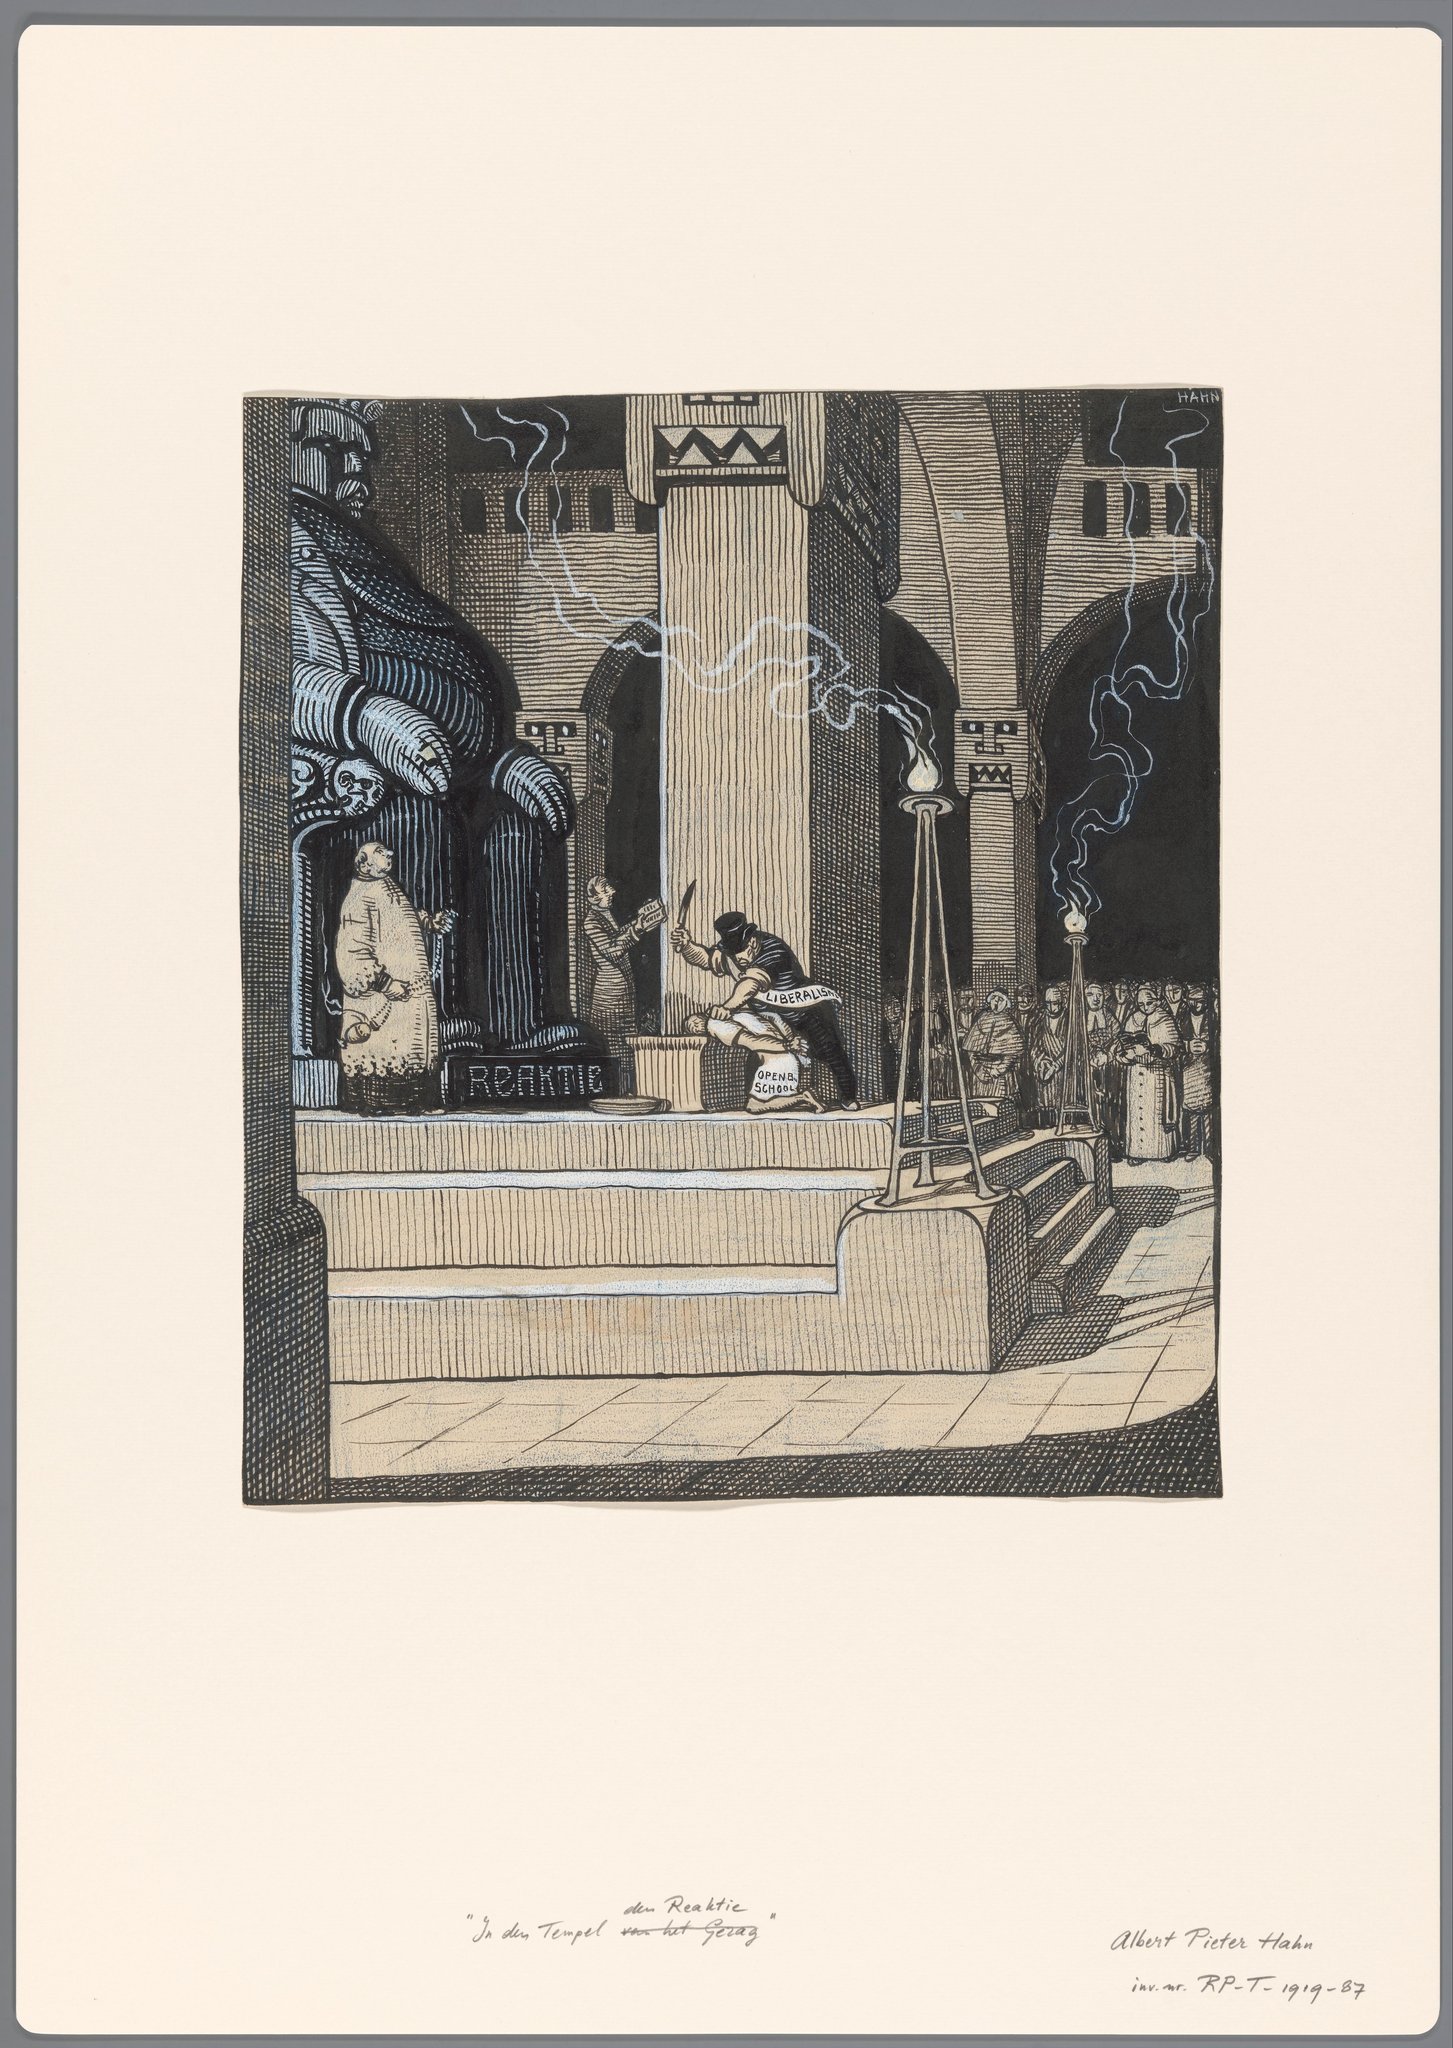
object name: drawing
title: Ontwerp voor een politieke spotprent: het offeren van de Openbare School door het Liberalisme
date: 1887-1919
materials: chalk, paint, ink, paper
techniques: brush, pen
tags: symbolic representations, allegories and emblems ~ education; 'ammaestramento', dottrina', 'educatione', 'istitutione' (ripa), political caricatures and satires